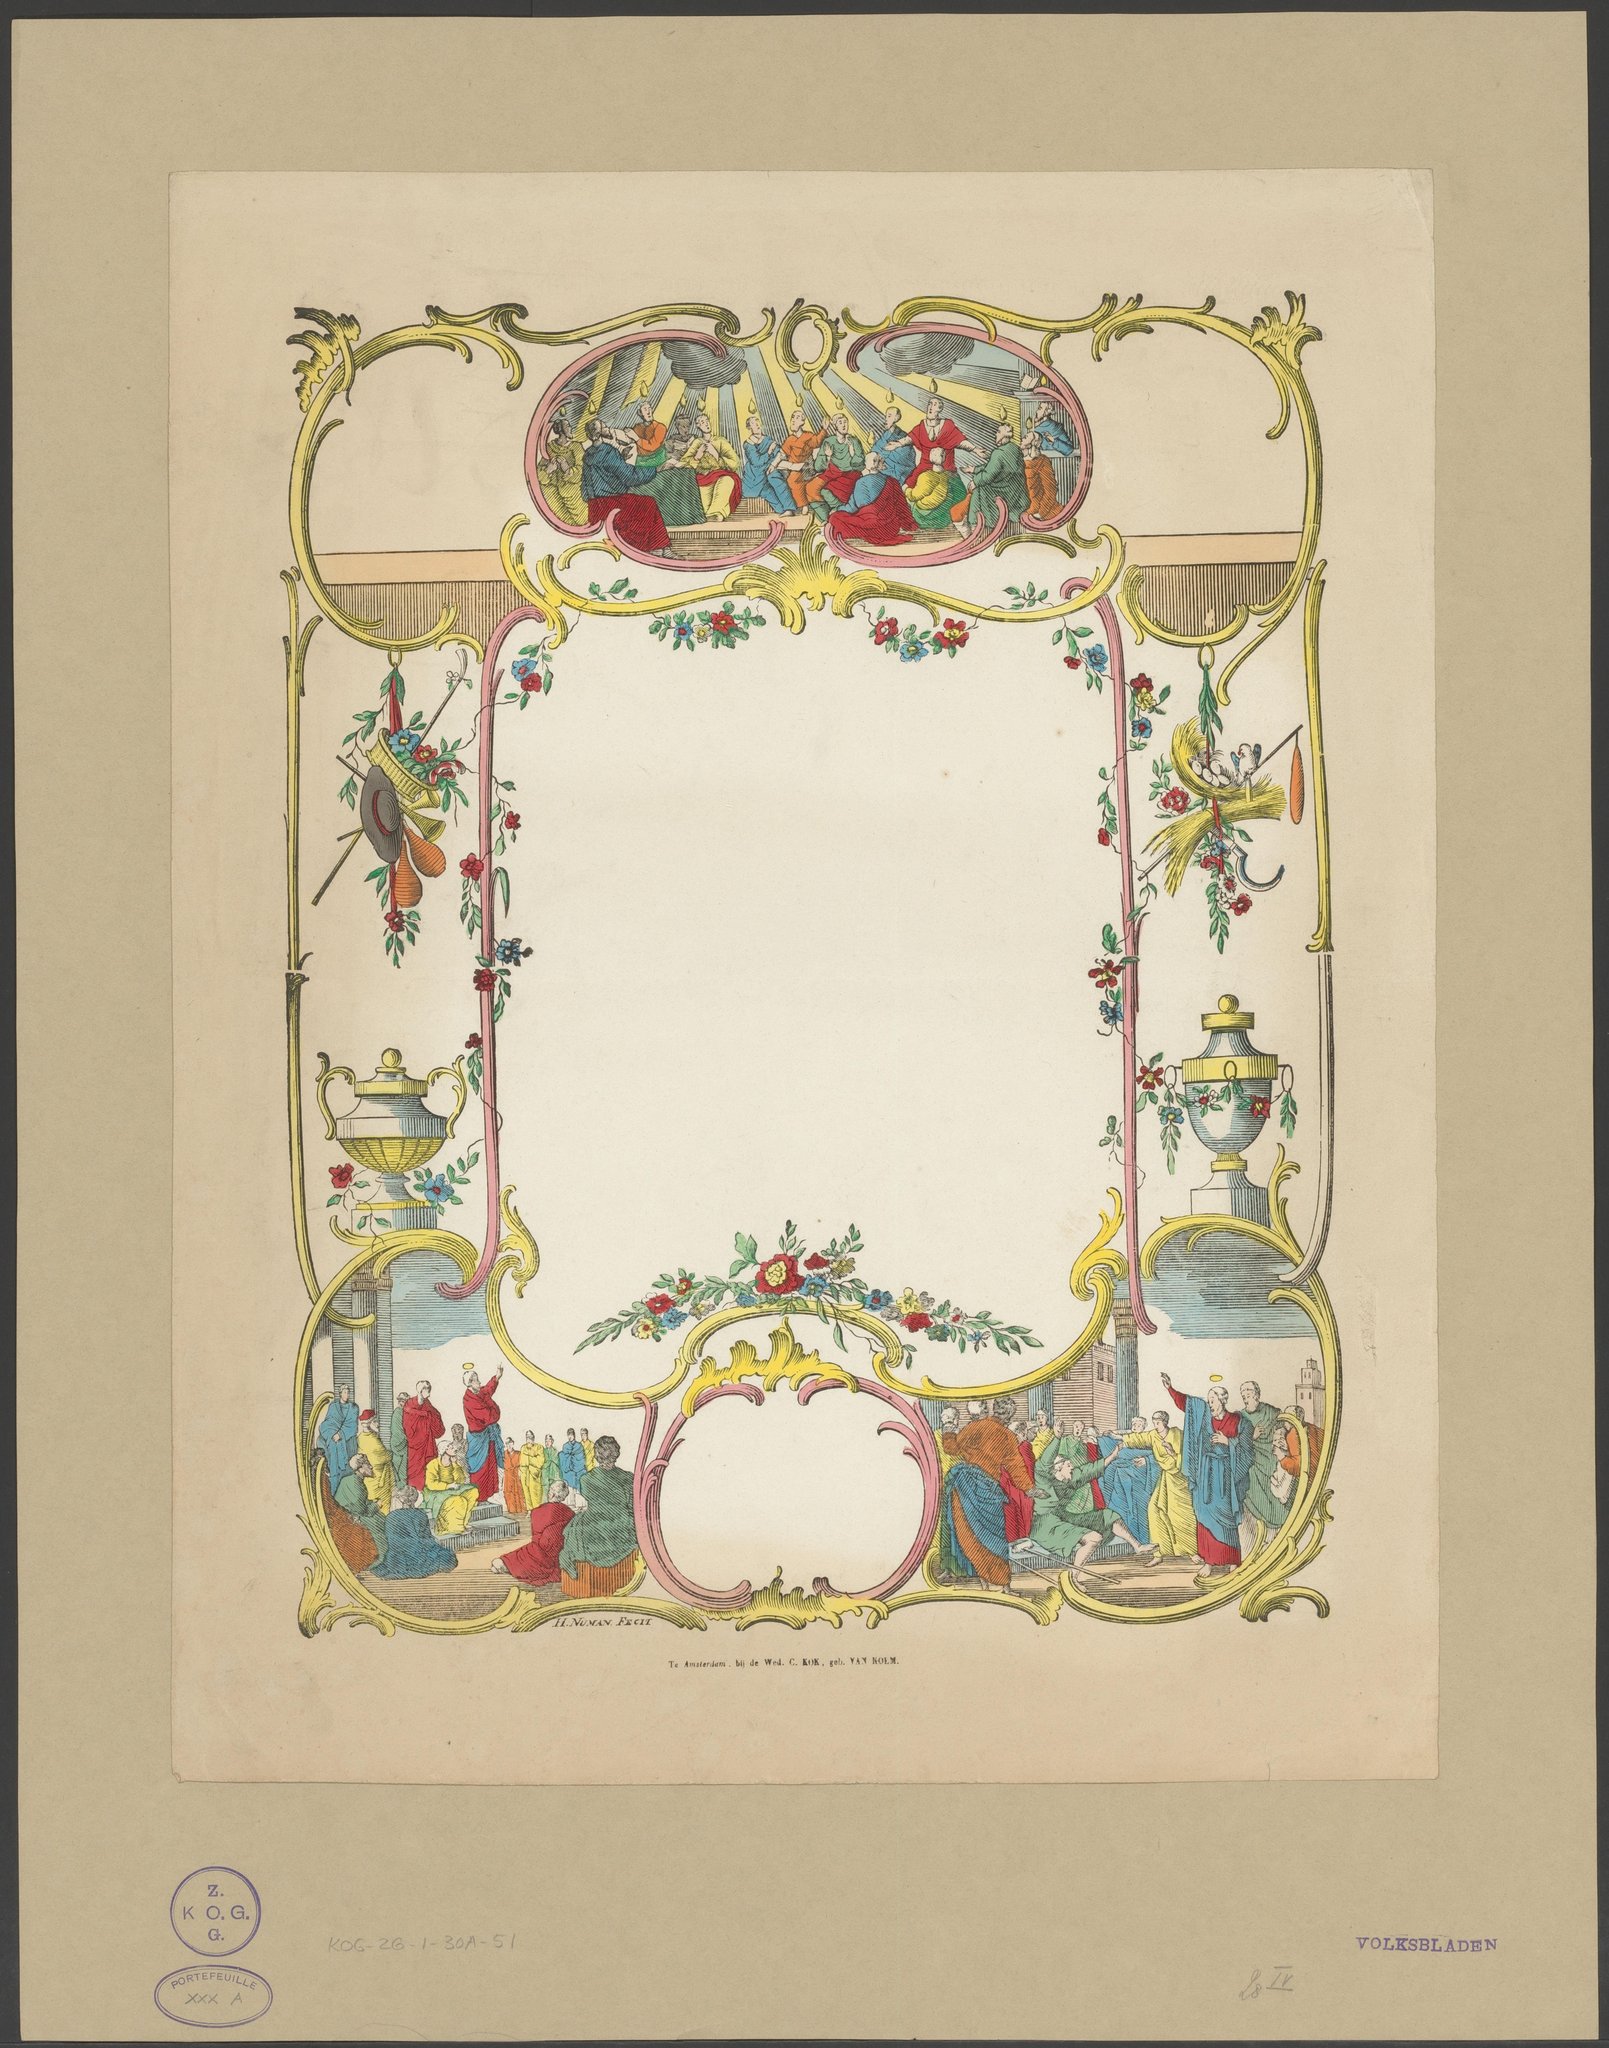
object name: print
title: Blanco wensbrief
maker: weduwe c. kok geboren van kolm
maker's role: printer, publisher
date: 1842-1866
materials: paper, watercolor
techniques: hand coloring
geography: amsterdam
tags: pentecost: the holy ghost descends upon (mary and) the apostles, sometimes paul and/or representatives of the nations present (acts 2:1-4)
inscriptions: collector's mark, collector's mark: Lugt 1641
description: Blanco wensbrief. Onbeschreven cartouche op een voorgedrukt blad met een kader gevormd door scènes van het verhaal van Pinksteren. Onderwerpsrubrieken binnen de Atlas Zeden en Gewoonten: Nieuwjaars- en kermiswenschen.